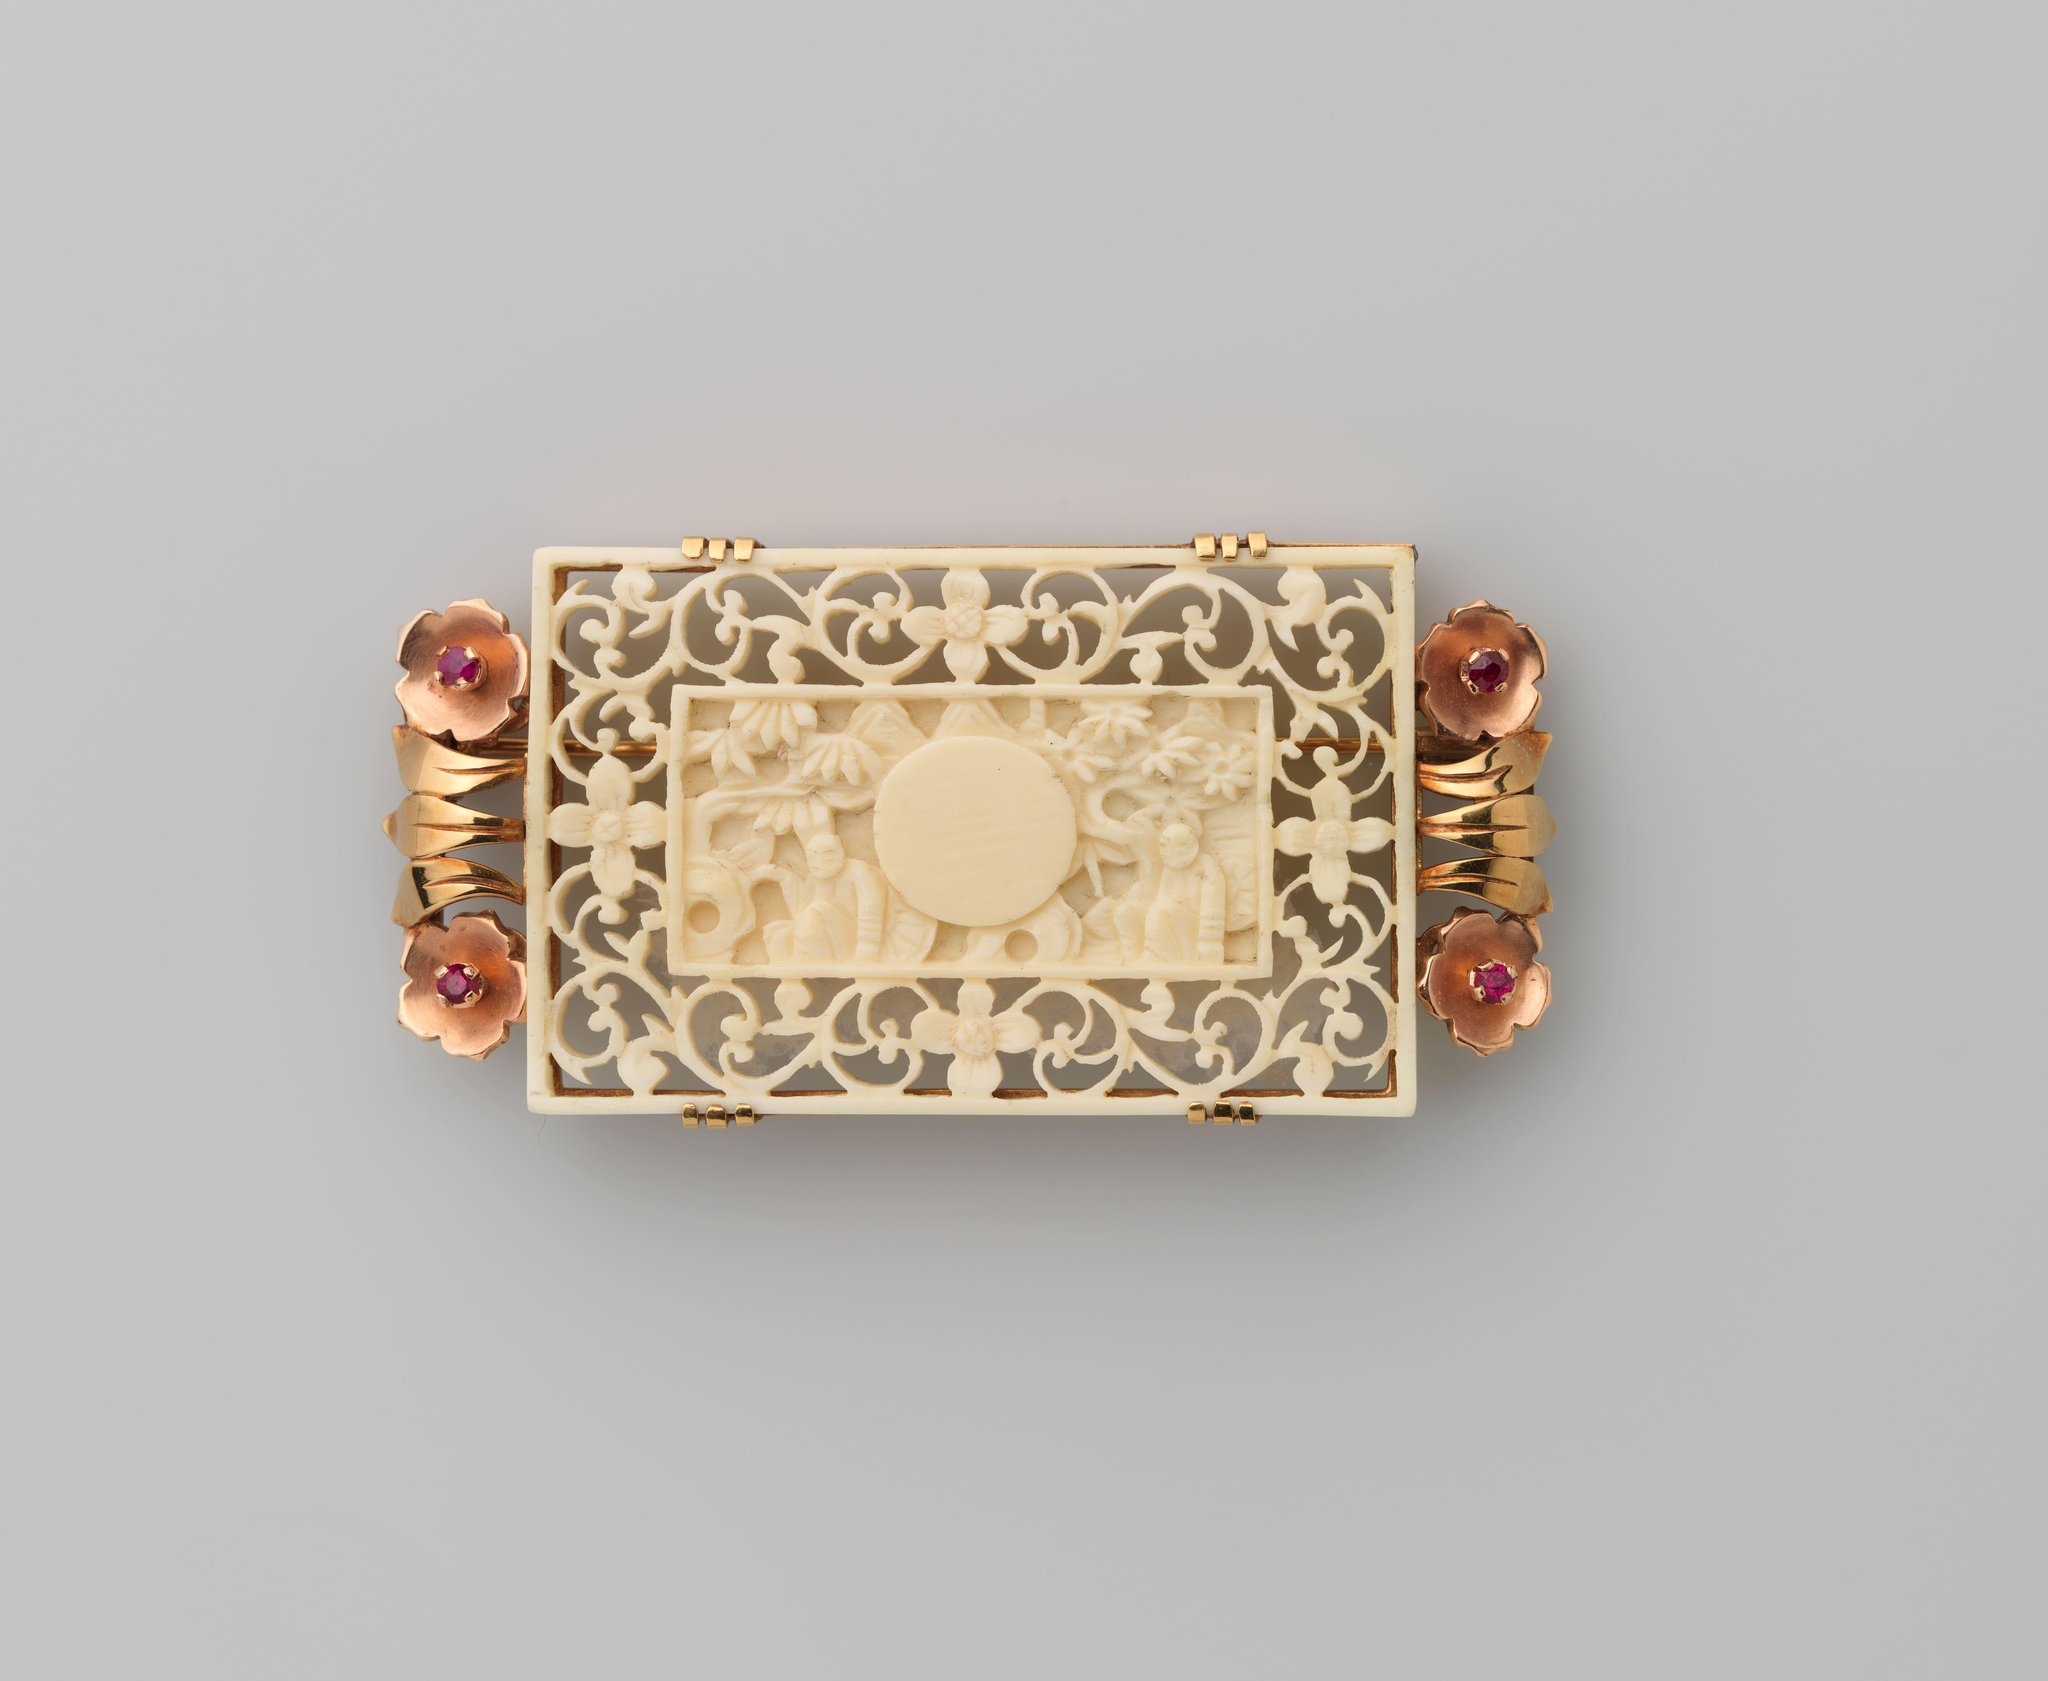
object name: brooch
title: Broche van rechthoekig gesneden been met twee kleuren goud en robijnen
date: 1945-1953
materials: bone, gold, gemstone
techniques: cutting, faceting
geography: the hague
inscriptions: alloy mark: ‘(oud) eikenblad’, maker's mark: ‘V.Z.K’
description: Broche van gesneden been met twee kleuren goud (geel en rood) en robijnen. Met aan weerszijden twee rozetten van roodgoud met daarin een rond gefacetteerde robijn. Één van de vier robijnen, linksboven, is synthetisch. De broche is voorzien van een kogelsluiting.